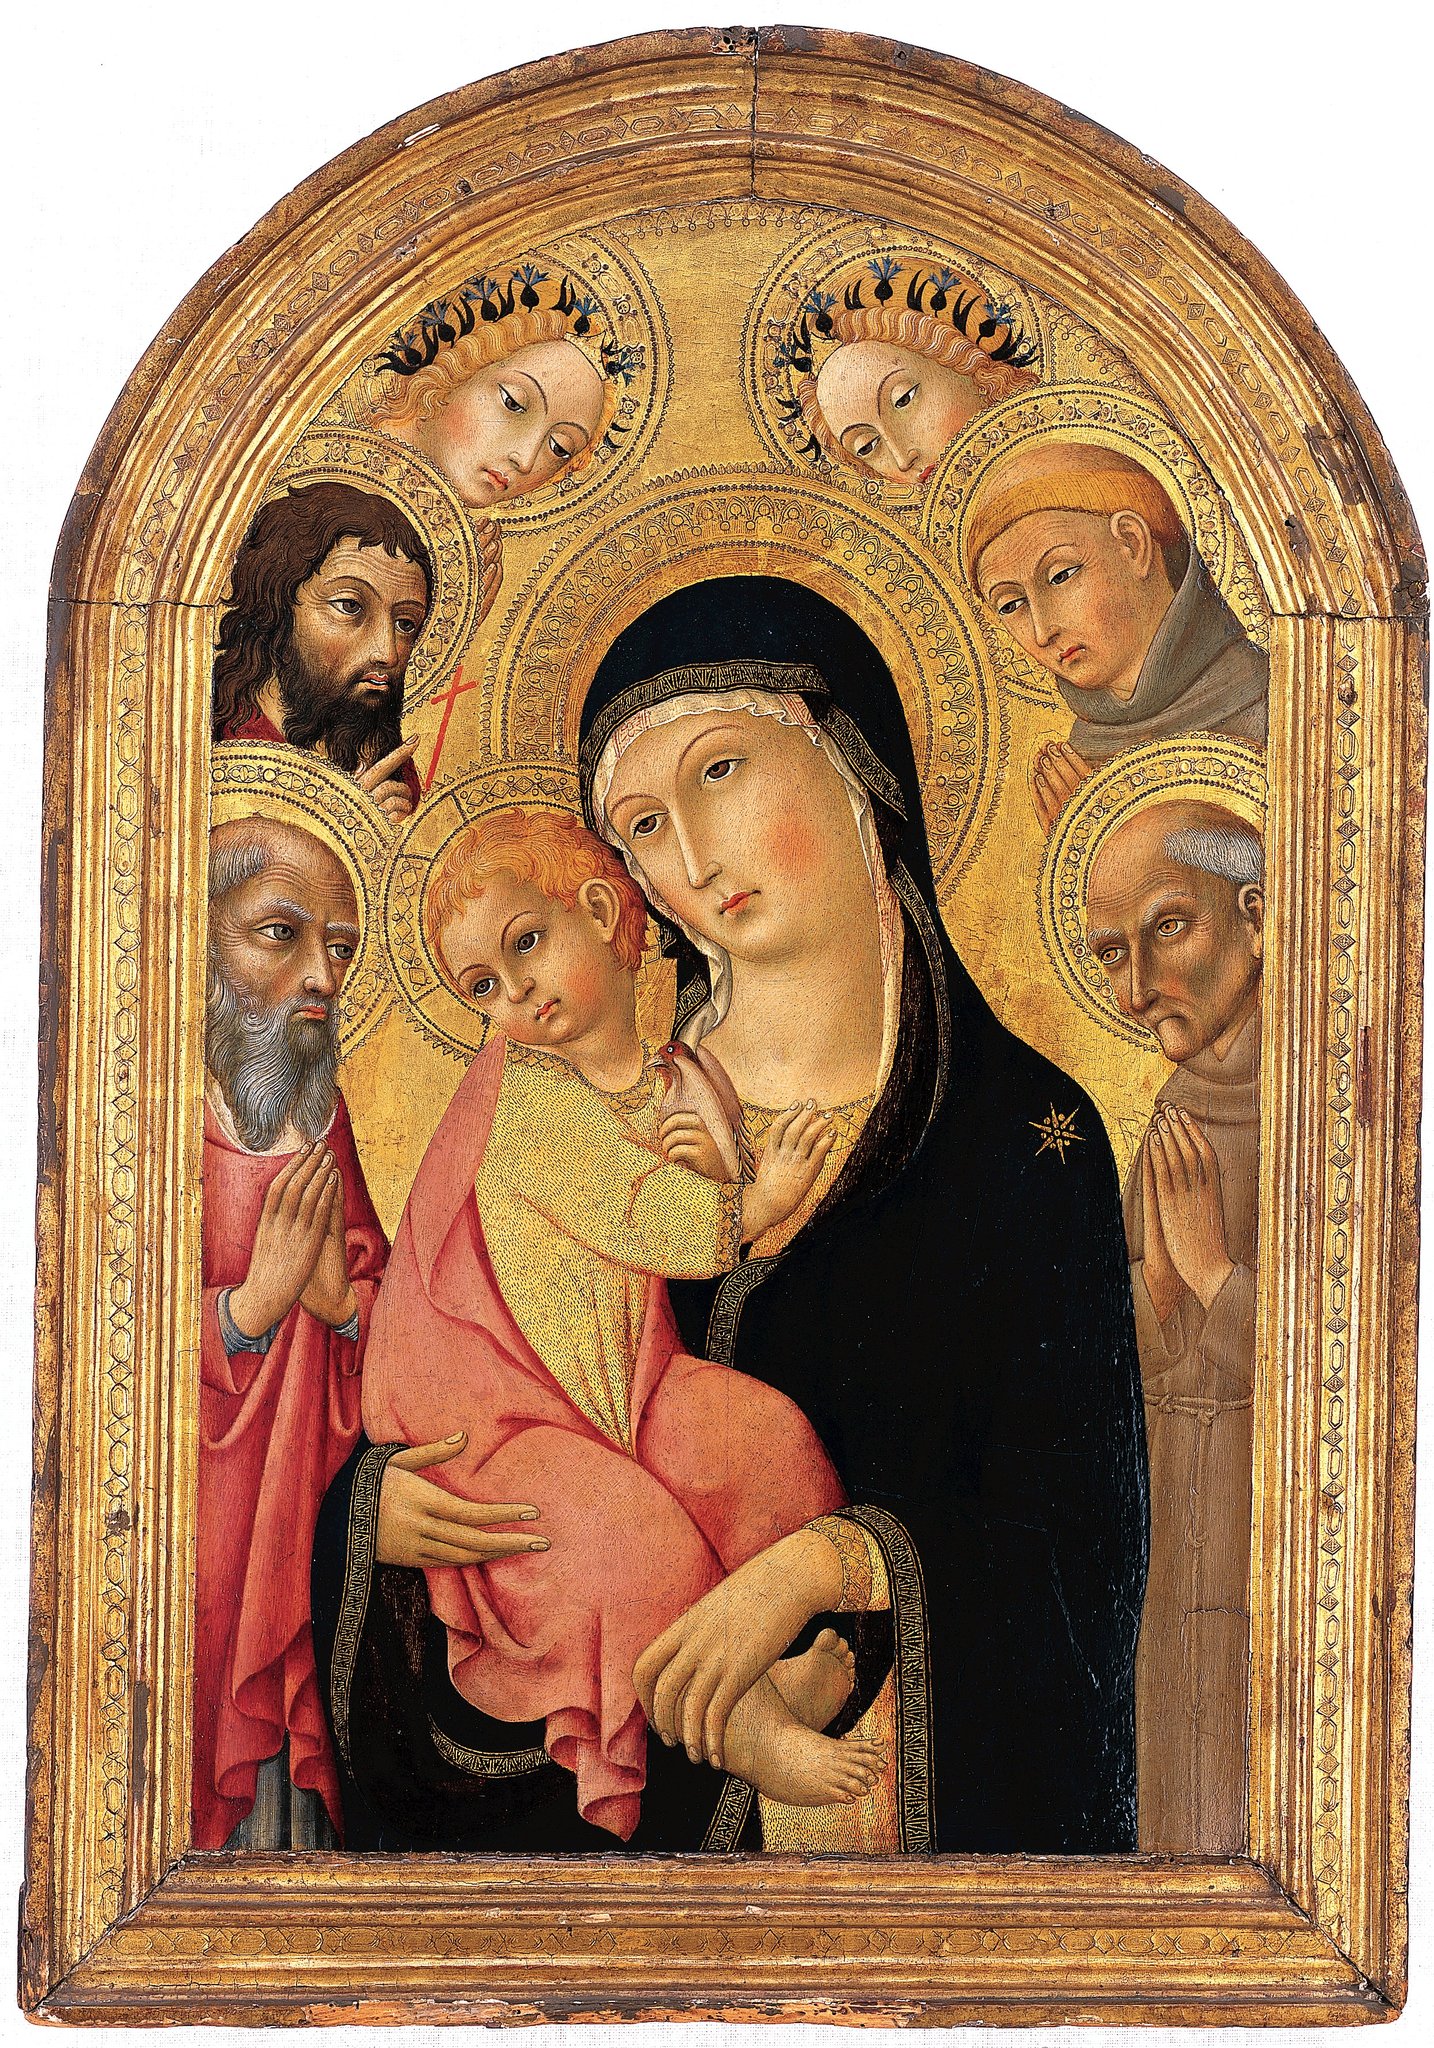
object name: frame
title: Engaged arched cassetta frame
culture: sienese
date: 1460-1470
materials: gilt, wood